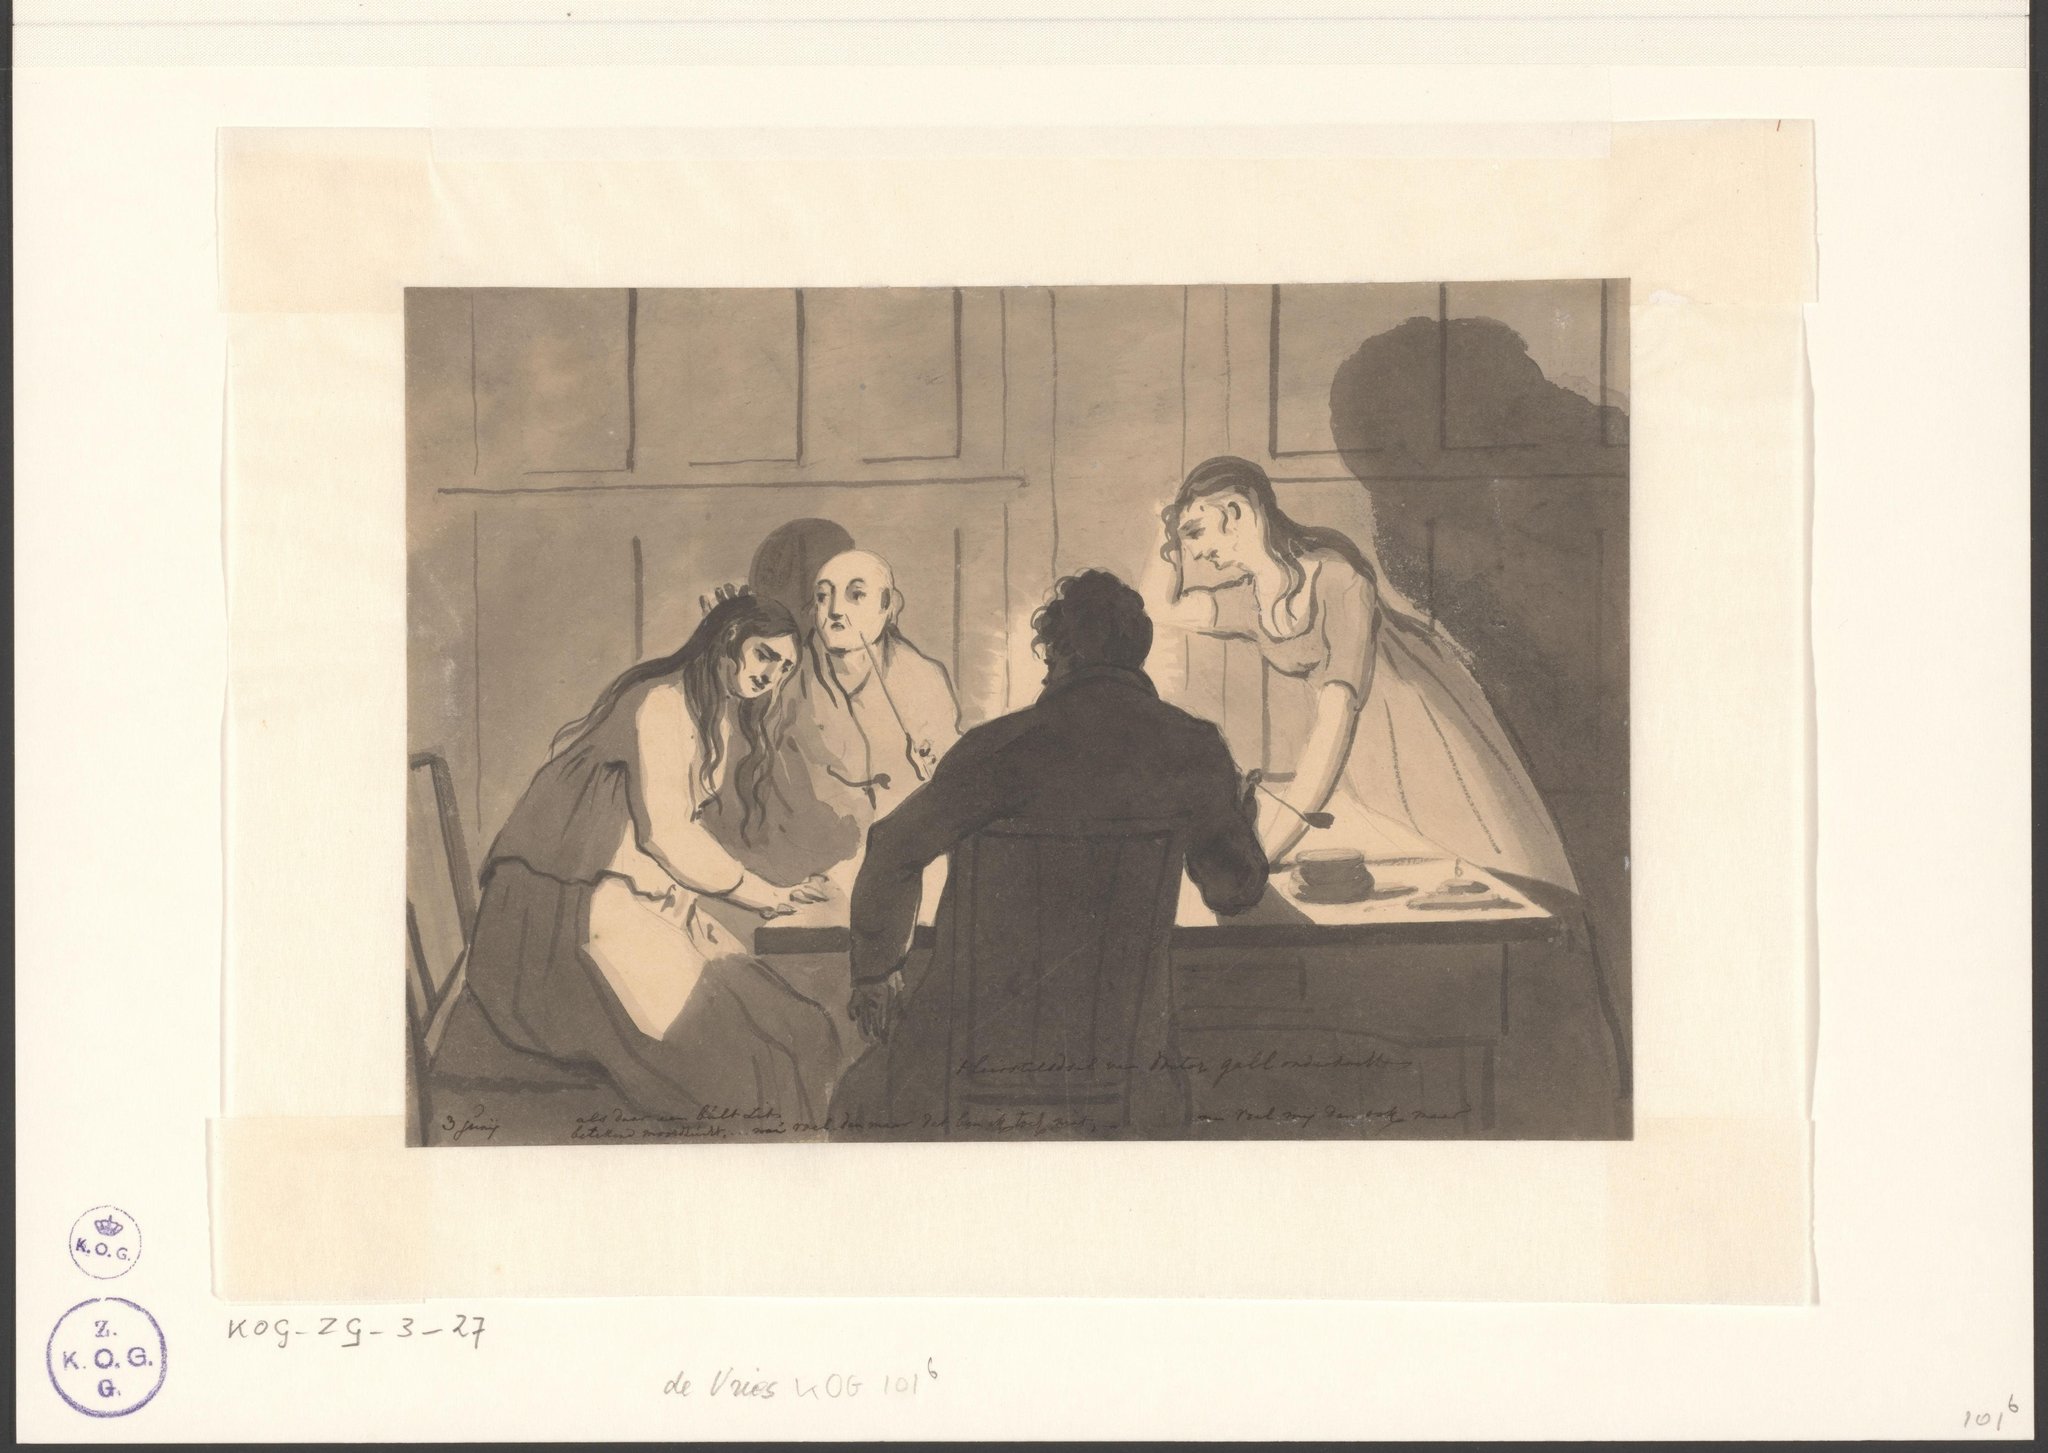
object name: drawing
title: Andriessen met een man en twee vrouwen bestuderen de theorieën van Franz Joseph Gall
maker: christiaan andriessen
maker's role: draughtsman, print maker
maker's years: 1775-1846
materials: ink, paper, pencil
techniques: brush, pen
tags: amsterdam, print maker, draughtsman, christiaan andriessen, standing figure, open window, index finger forwards, pointing, indicating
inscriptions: inscription: ‘J Andriessen’, inscription: ‘'t Leersteldsel van Doctor Gall onderzocht (...)’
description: Dagboekblad uit het getekende dagboek dat Christiaan Andriessen bijhield van 1805 tot en met 1808.